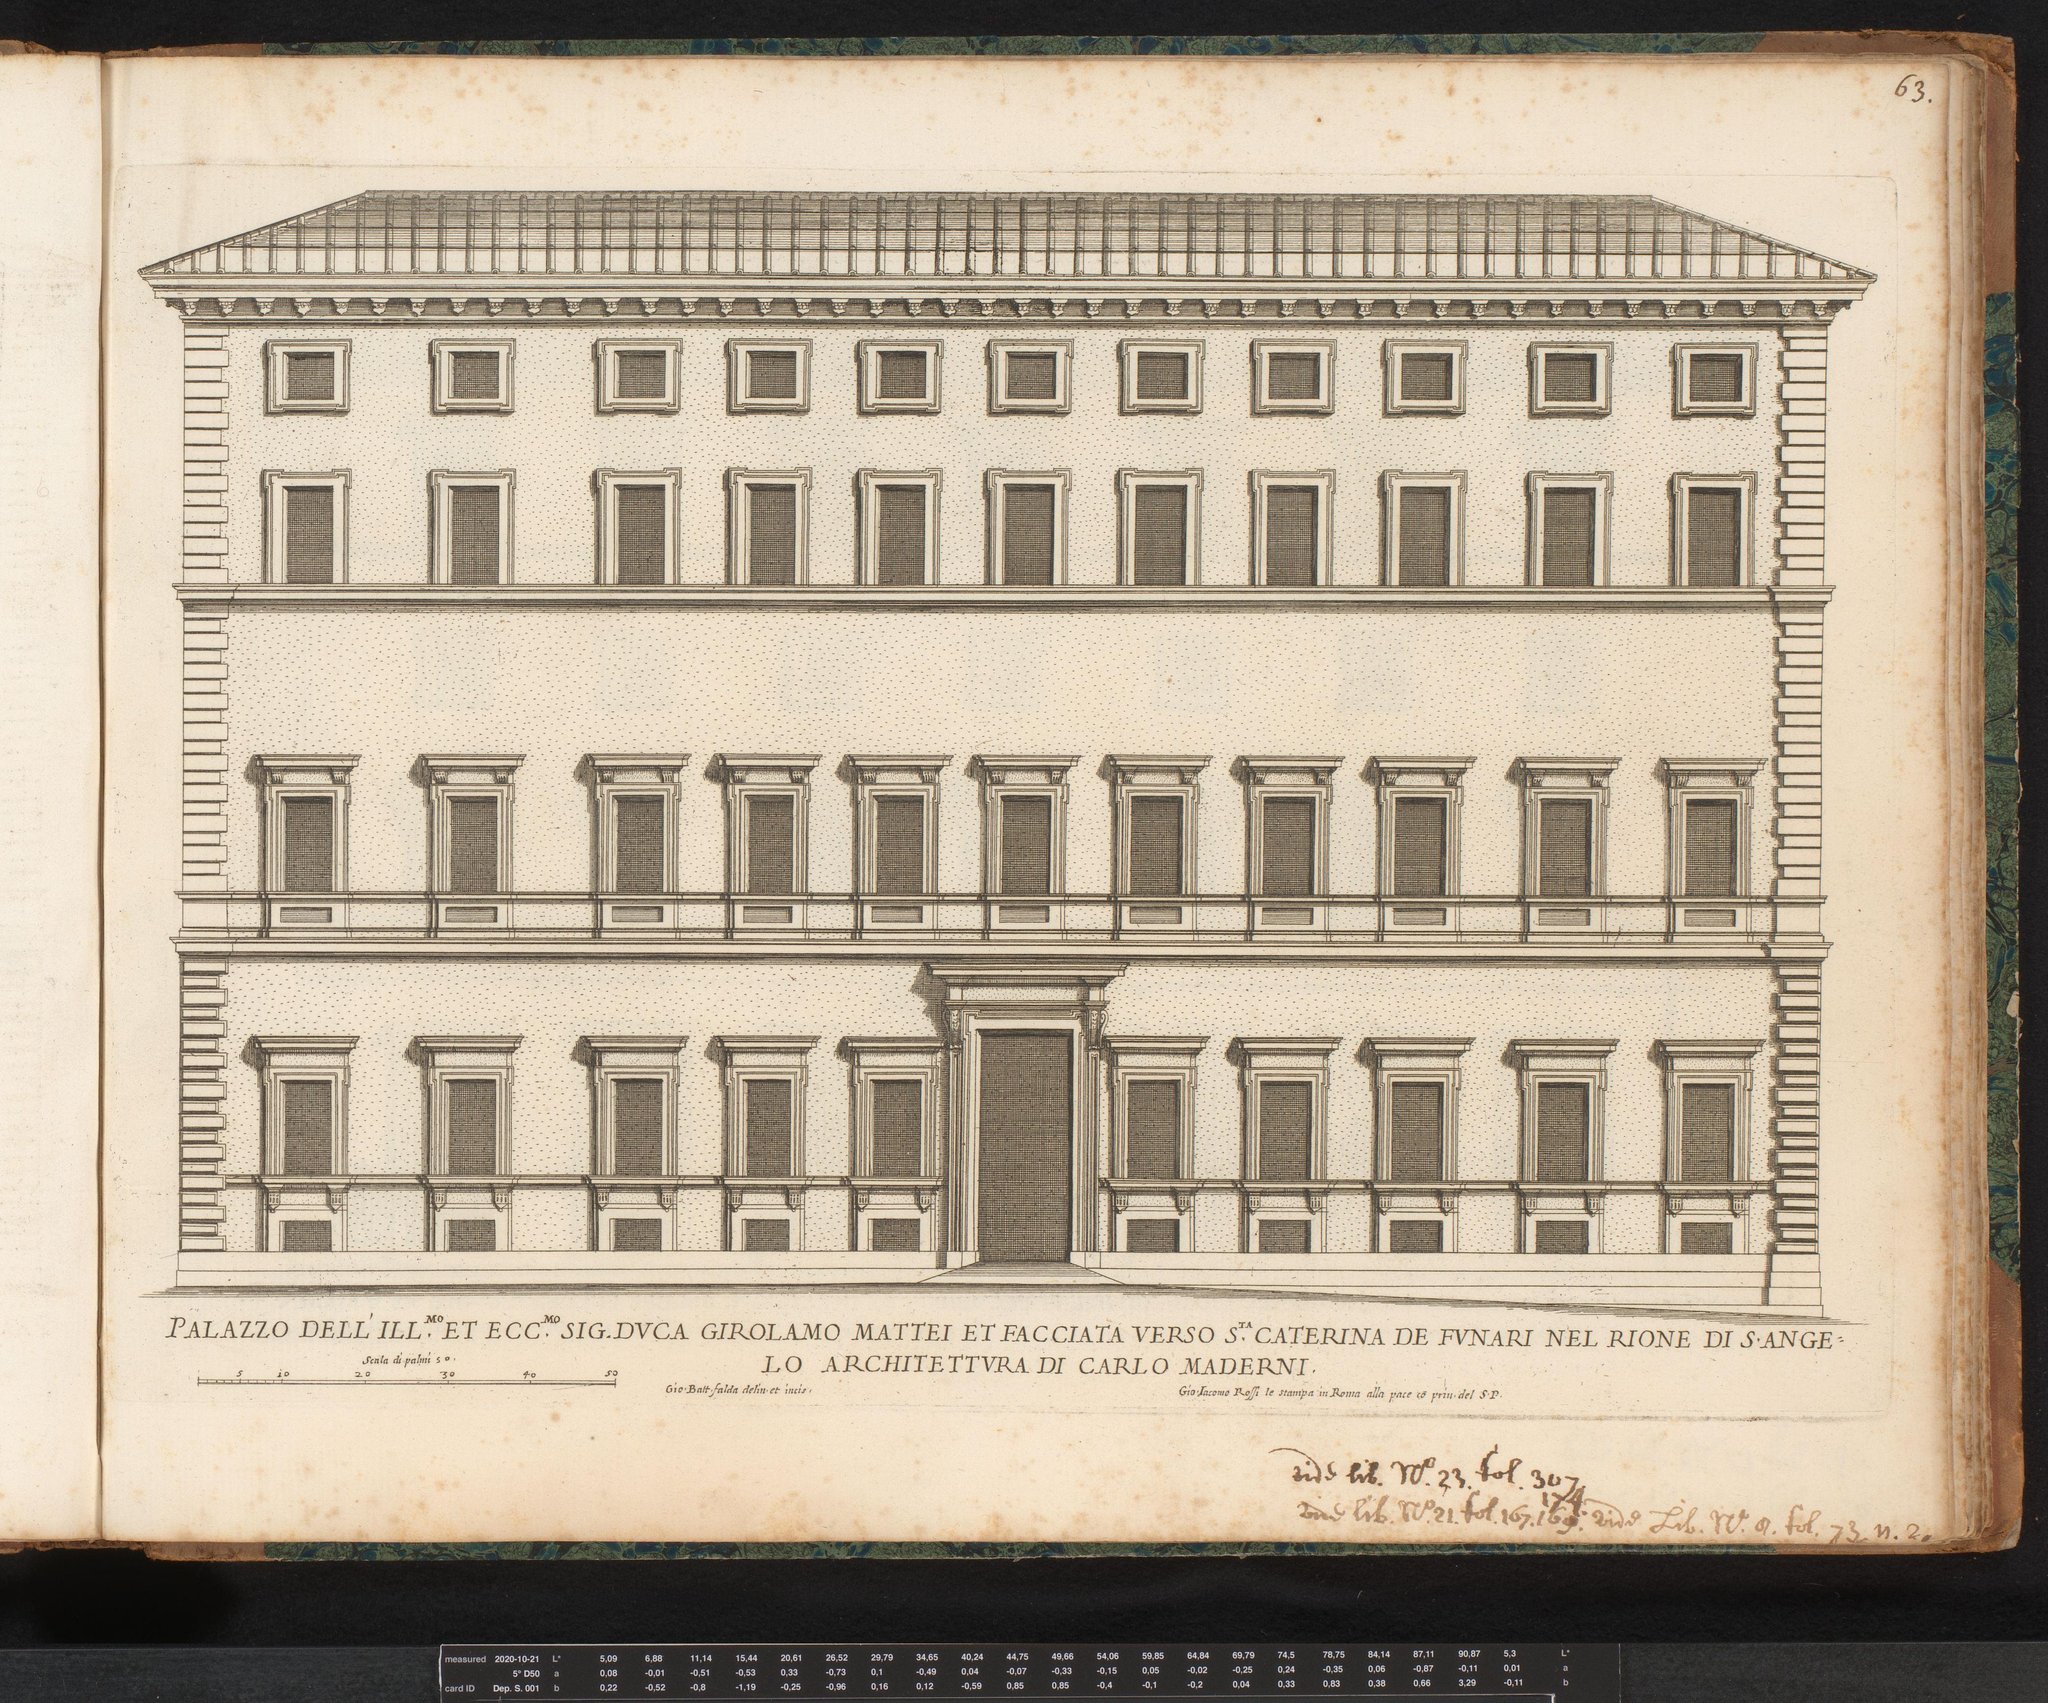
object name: album leaf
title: Façade van het paleis van hertog Mattei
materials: paper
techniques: etching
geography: italy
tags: palace, façade (of house or building), rome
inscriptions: number: ‘63’, inscription: ‘Ende lib. No. 23. fol. 30./ Ende lib. No. 21. fol. 167. 169...’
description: Deze prent maakt deel uit van de reeks getiteld: Palazzi di Roma. Deze reeks bestaat uit twee boeken. Boek één getiteld: Palazzi di Roma dei più celebri architetti..., bestaat uit 44 prenten die worden toegeschreven aan Giovanni Battista Falda (naam staat enkel op prent 27) en uitgegeven door Giovanni Giacomo de'Rossi. Deze 44 prenten zijn bekend in twee staten (met en zonder nummer). Boek twee getiteld: Nuovi disegni dell'architetture... libro secondo, bevat 66 prenten door Giovanni Battista Falda en Simone Felice. Deze 66 prenten zijn bekend in twee staten (met en zonder nummer).